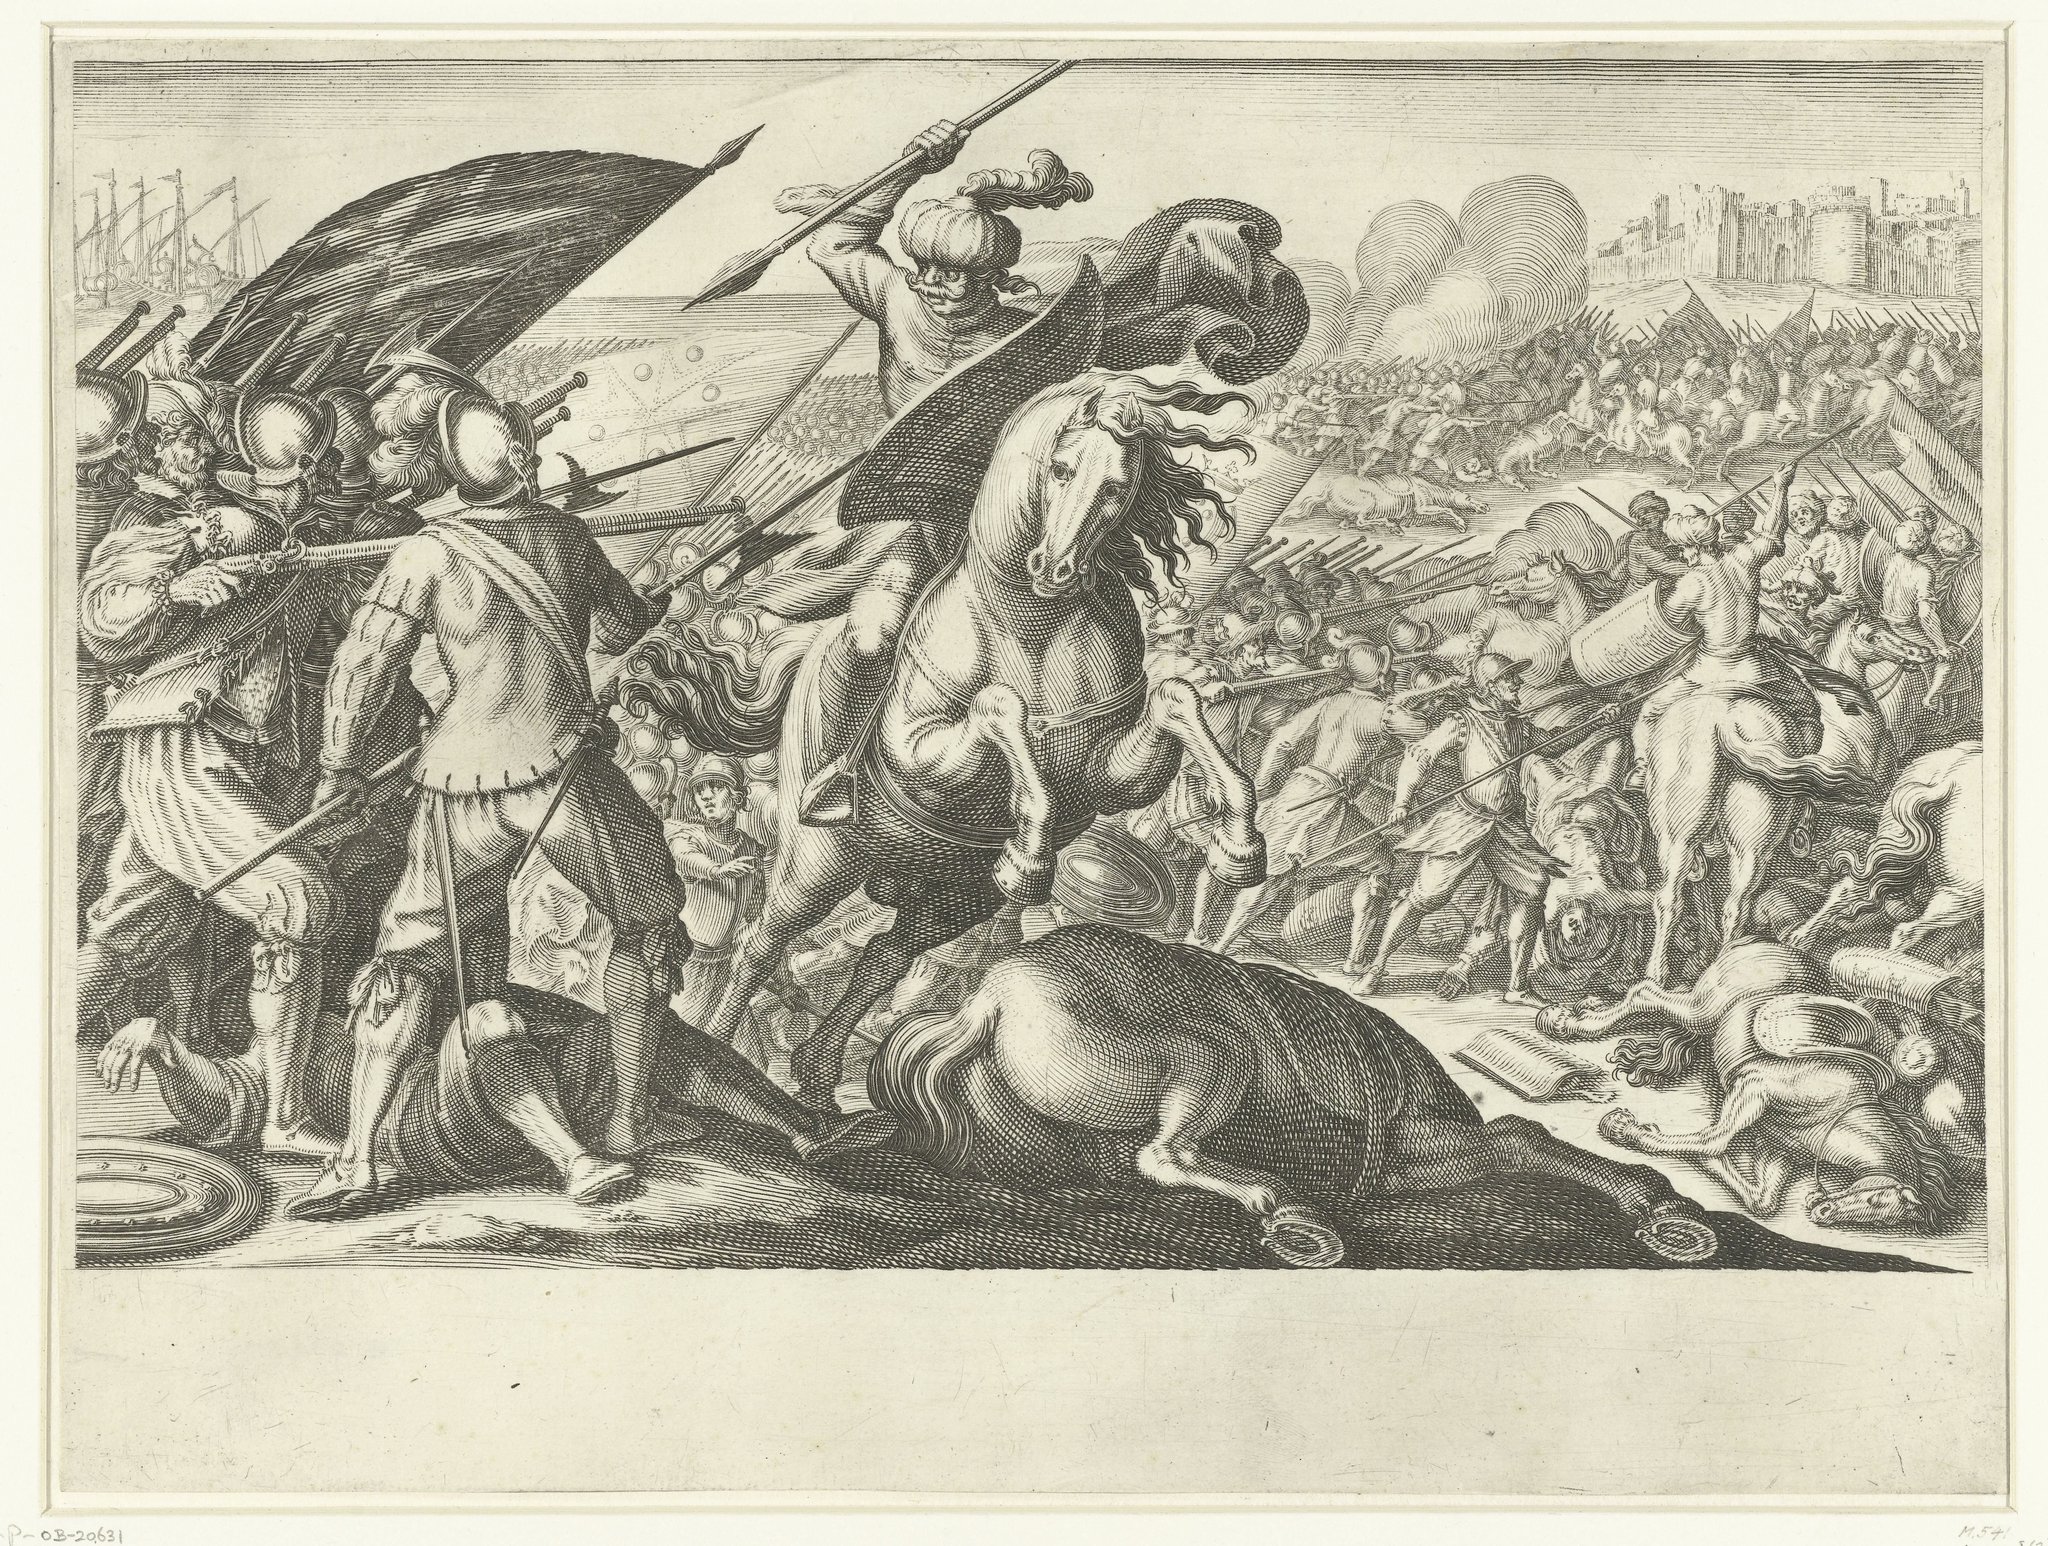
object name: print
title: De troepen van Ferdinando I de' Medici winnen de strijd tegen de Turkse cavalerie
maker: jacques callot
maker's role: draughtsman, print maker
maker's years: 1592-1635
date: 1614-1620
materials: paper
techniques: engraving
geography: florence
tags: ferdinando i de' medici, asiatic races and peoples: turks, battle, warfare; military affairs (+ cavalry, horsemen)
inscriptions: collector's mark: Lugt 240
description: Te midden van een strijdgewoel in de nabijheid van een stad heft een Turkse ruiter zijn speer om op soldaten van Ferdinando de' Medici in te hakken. Onder de voorstelling een lege marge. Deze prent is onderdeel van een serie van 16 prenten (plus 2 onvoltooide prenten) van het leven van Ferdinando I de' Medici, bedoeld geweest als aanvulling op een reeds bestaande reeks illustraties van de geschiedenis van de Medicis.